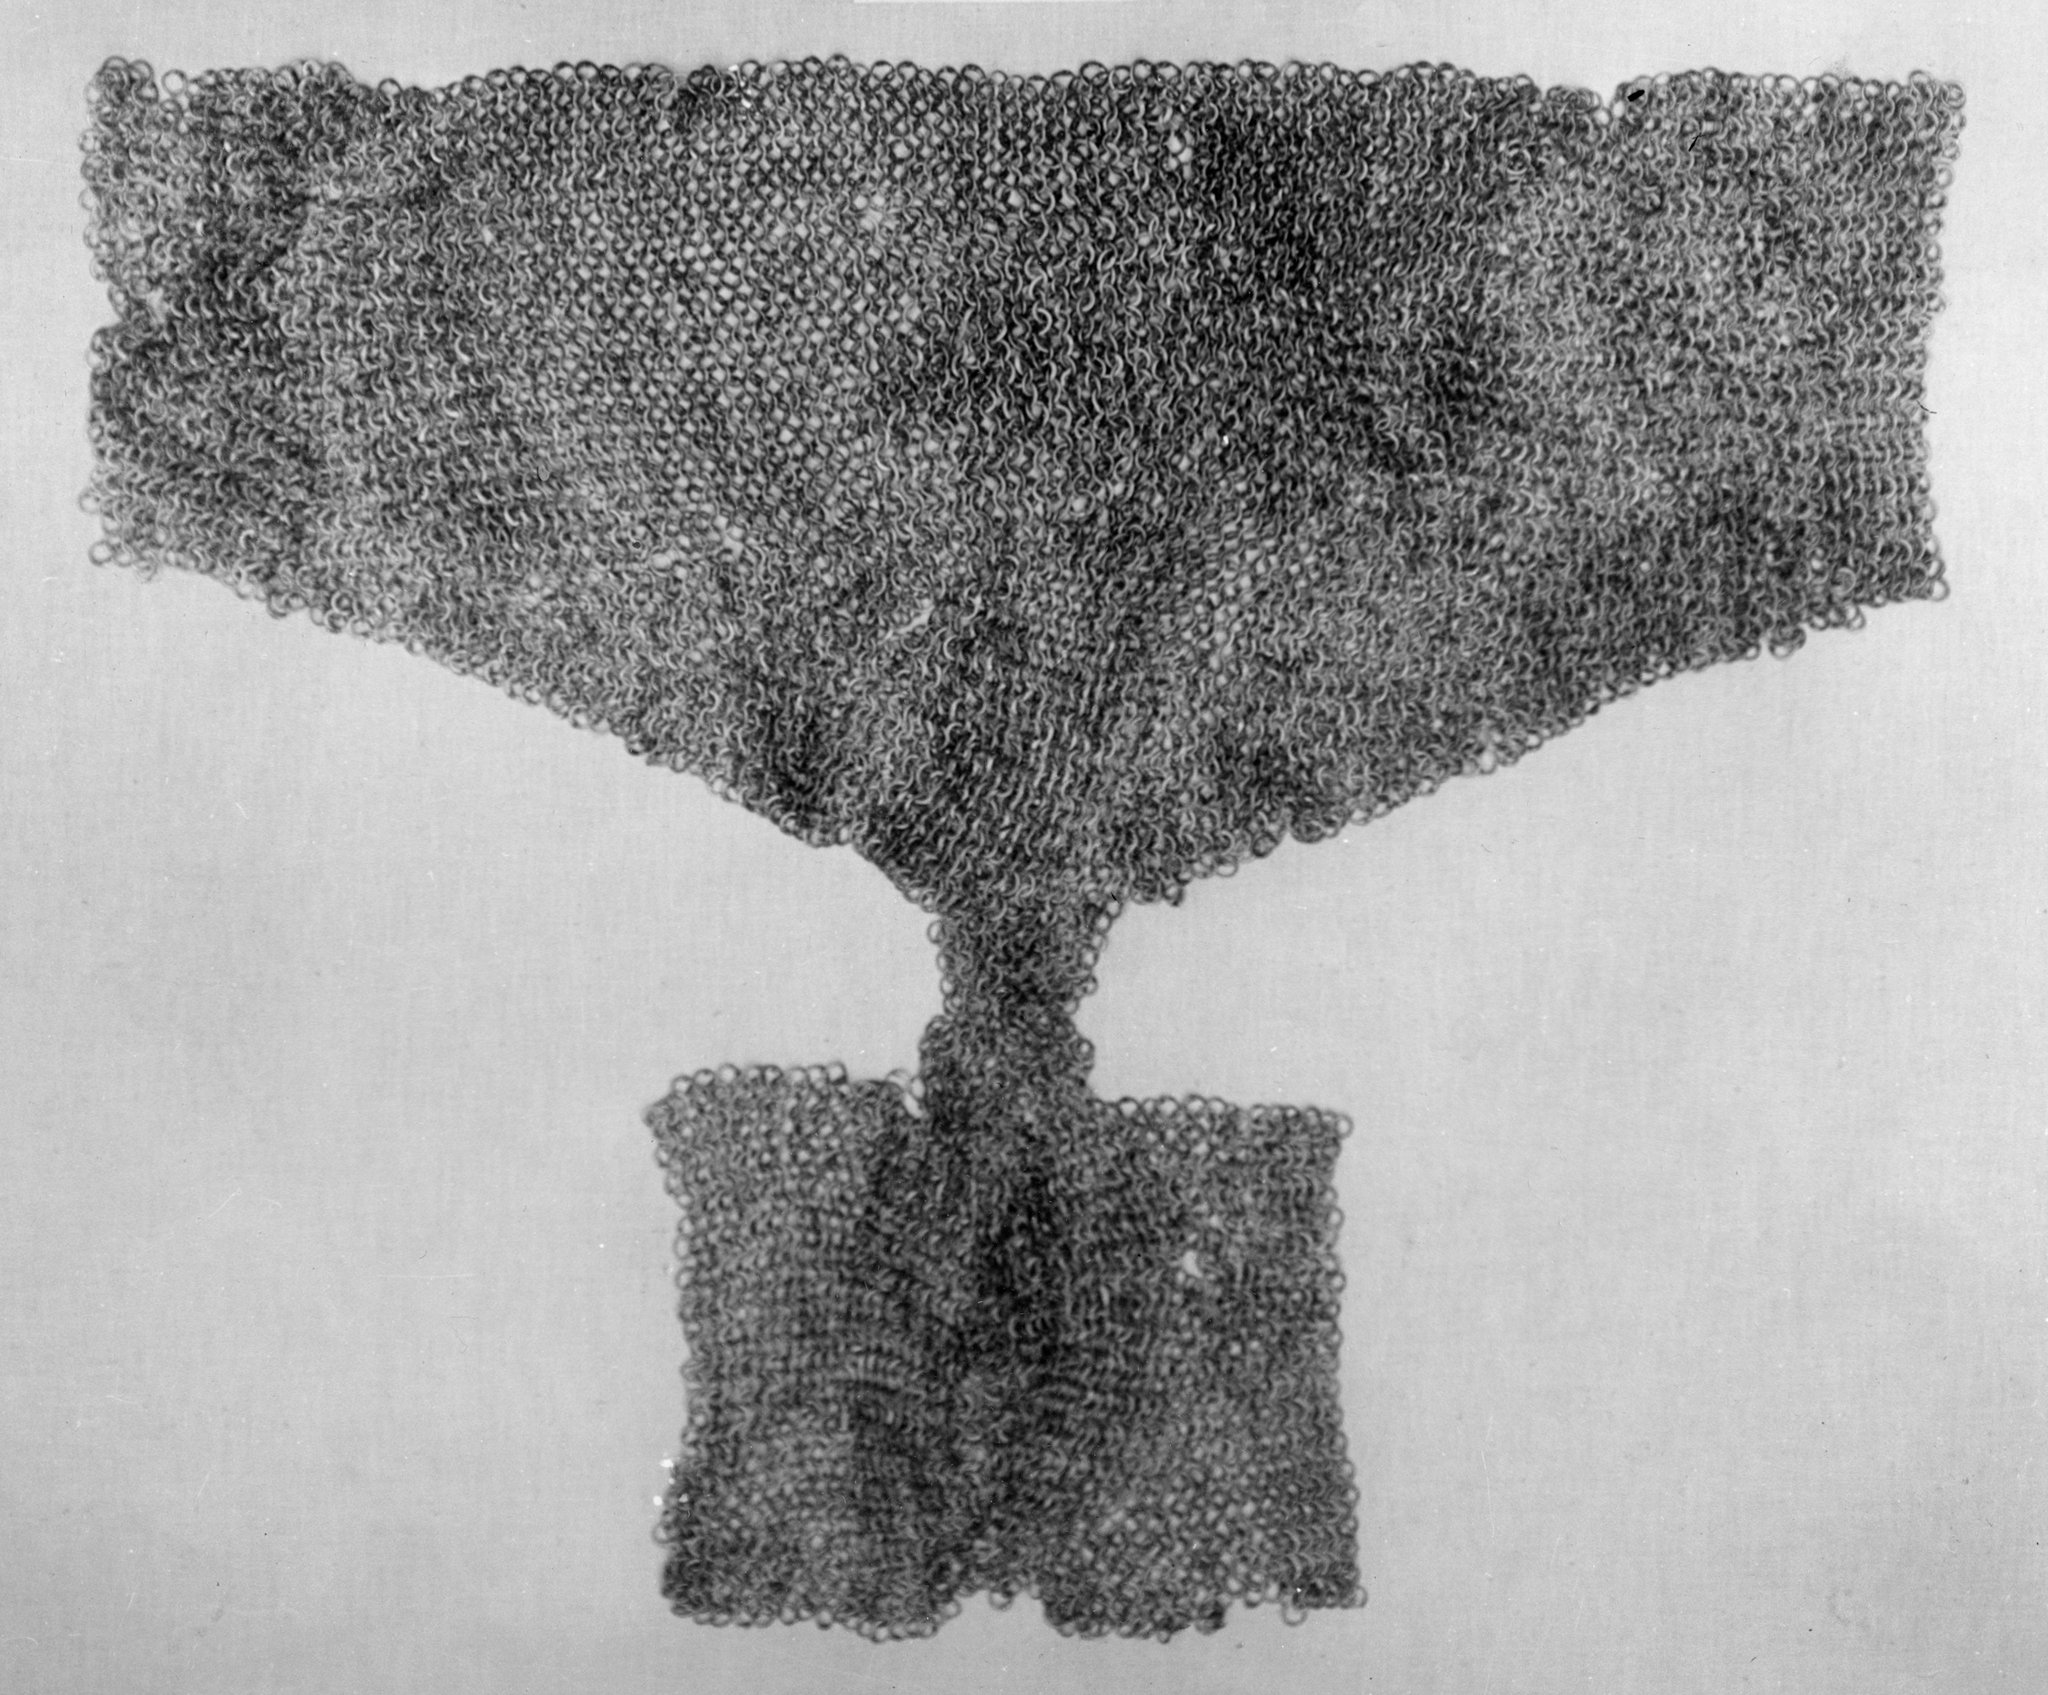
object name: brayette and buttock defense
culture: german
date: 1501-1600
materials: steel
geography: germany